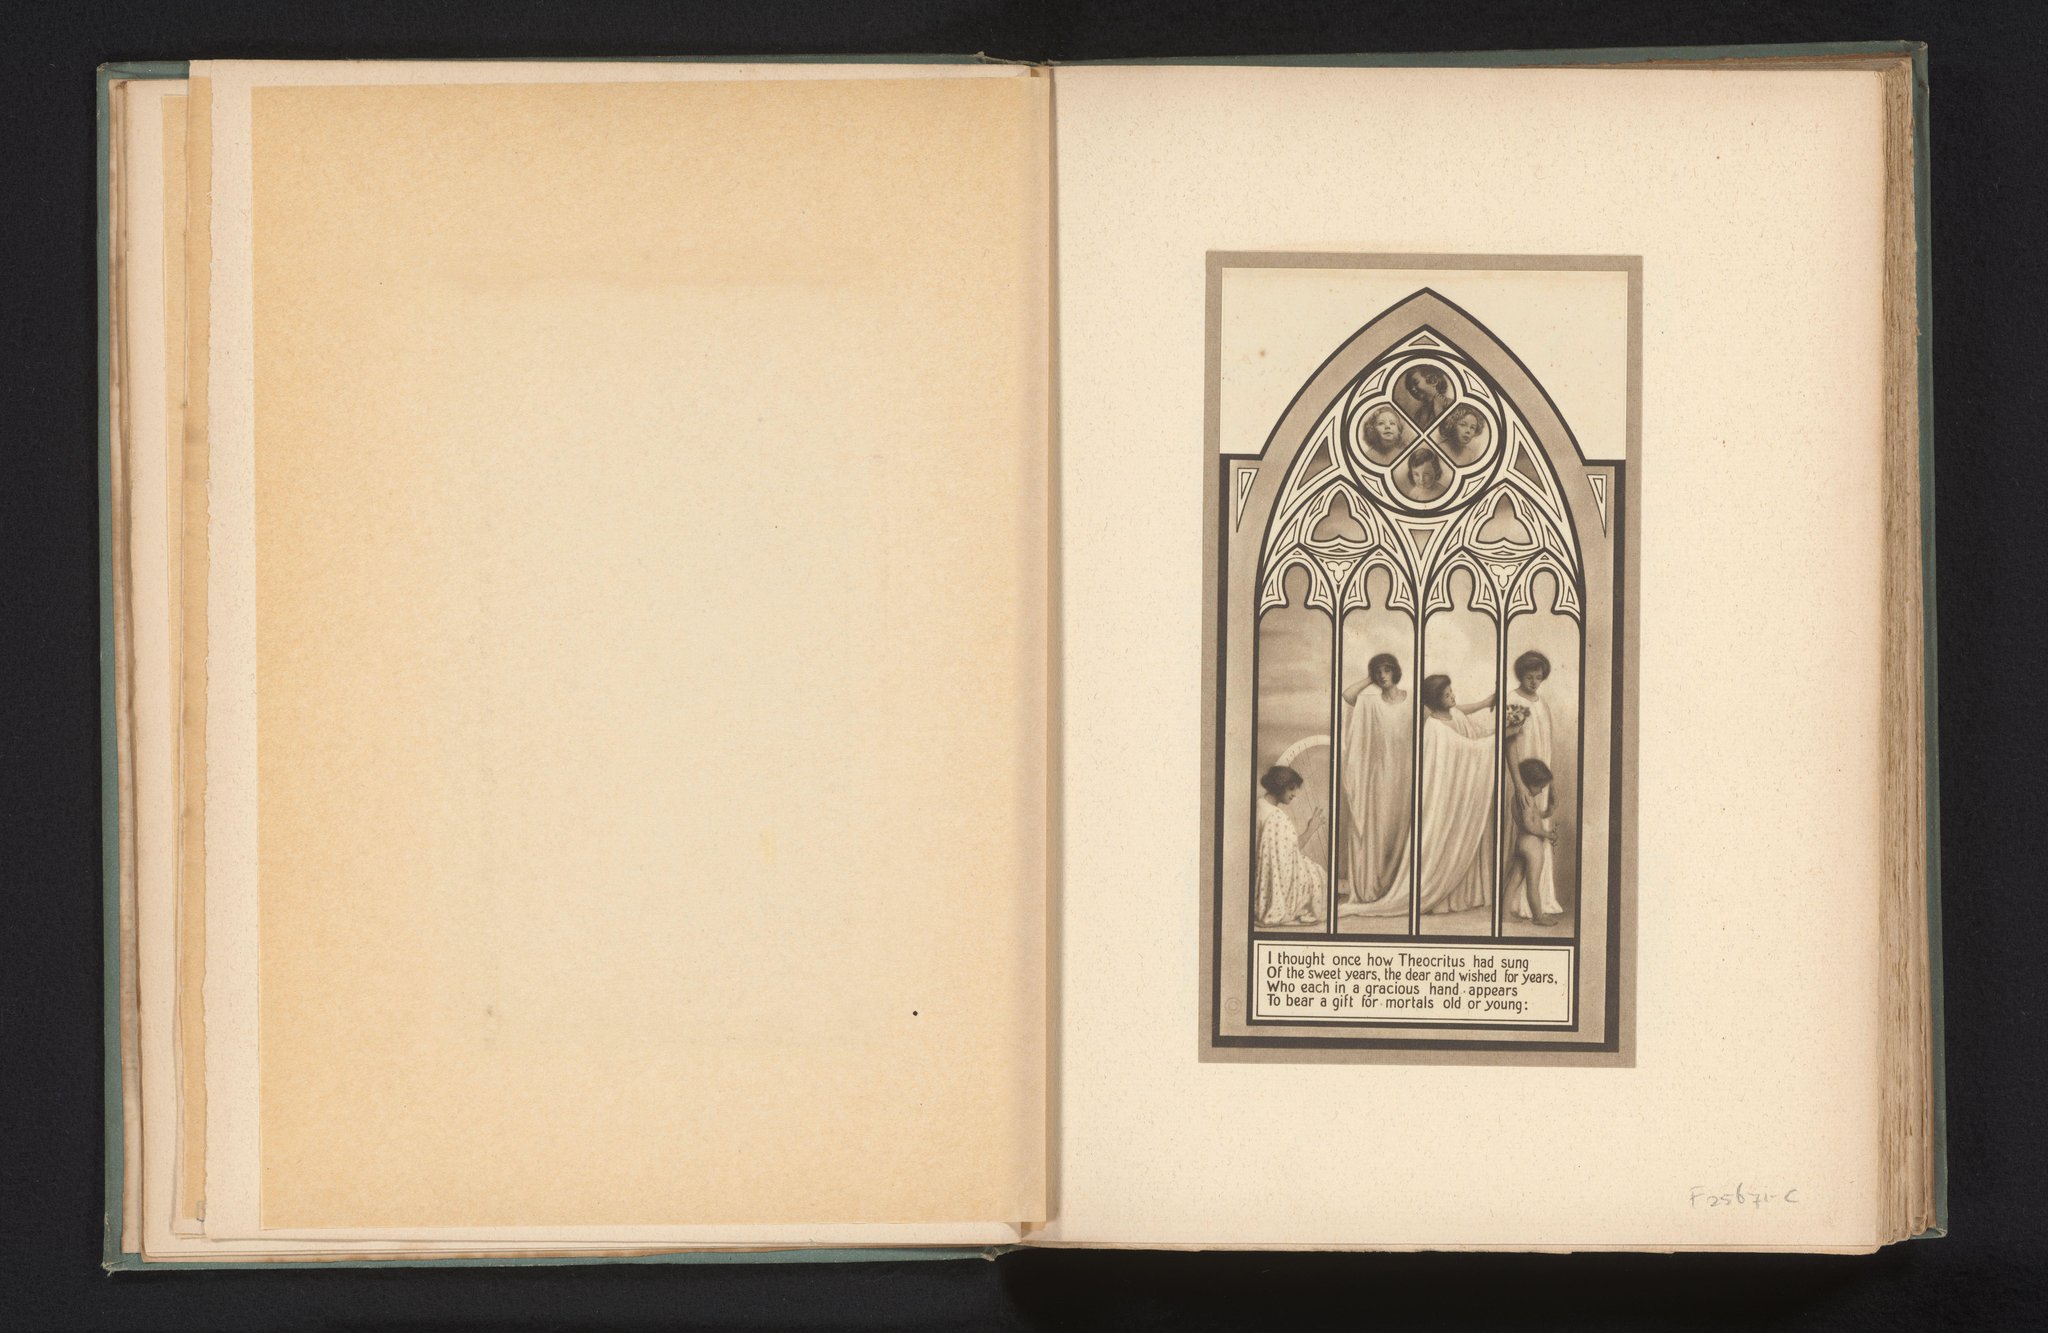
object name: photomechanical print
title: Vier vrouwen en een kind achter een kerkraam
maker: adelaide hanscom leeson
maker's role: painter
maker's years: 1875-1931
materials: cardboard, paper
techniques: photoaquatint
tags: church-window, e.g. rose-window, picture, painting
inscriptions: copyright notice: ‘C’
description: Prent op ongenummerde pagina. Adelaide Hanscom Leeson manipuleerde haar glasnegatieven om een schilderachtig efffect te bewerkstelligen.